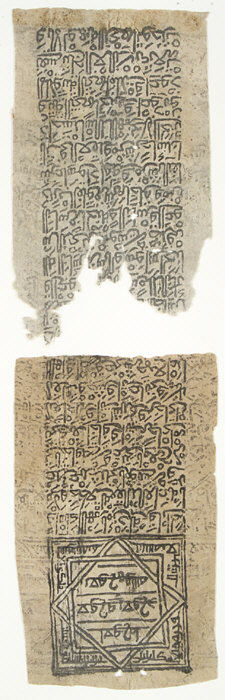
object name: scroll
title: Talismanic Scroll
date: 1001-1100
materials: ink, paper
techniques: printing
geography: egypt